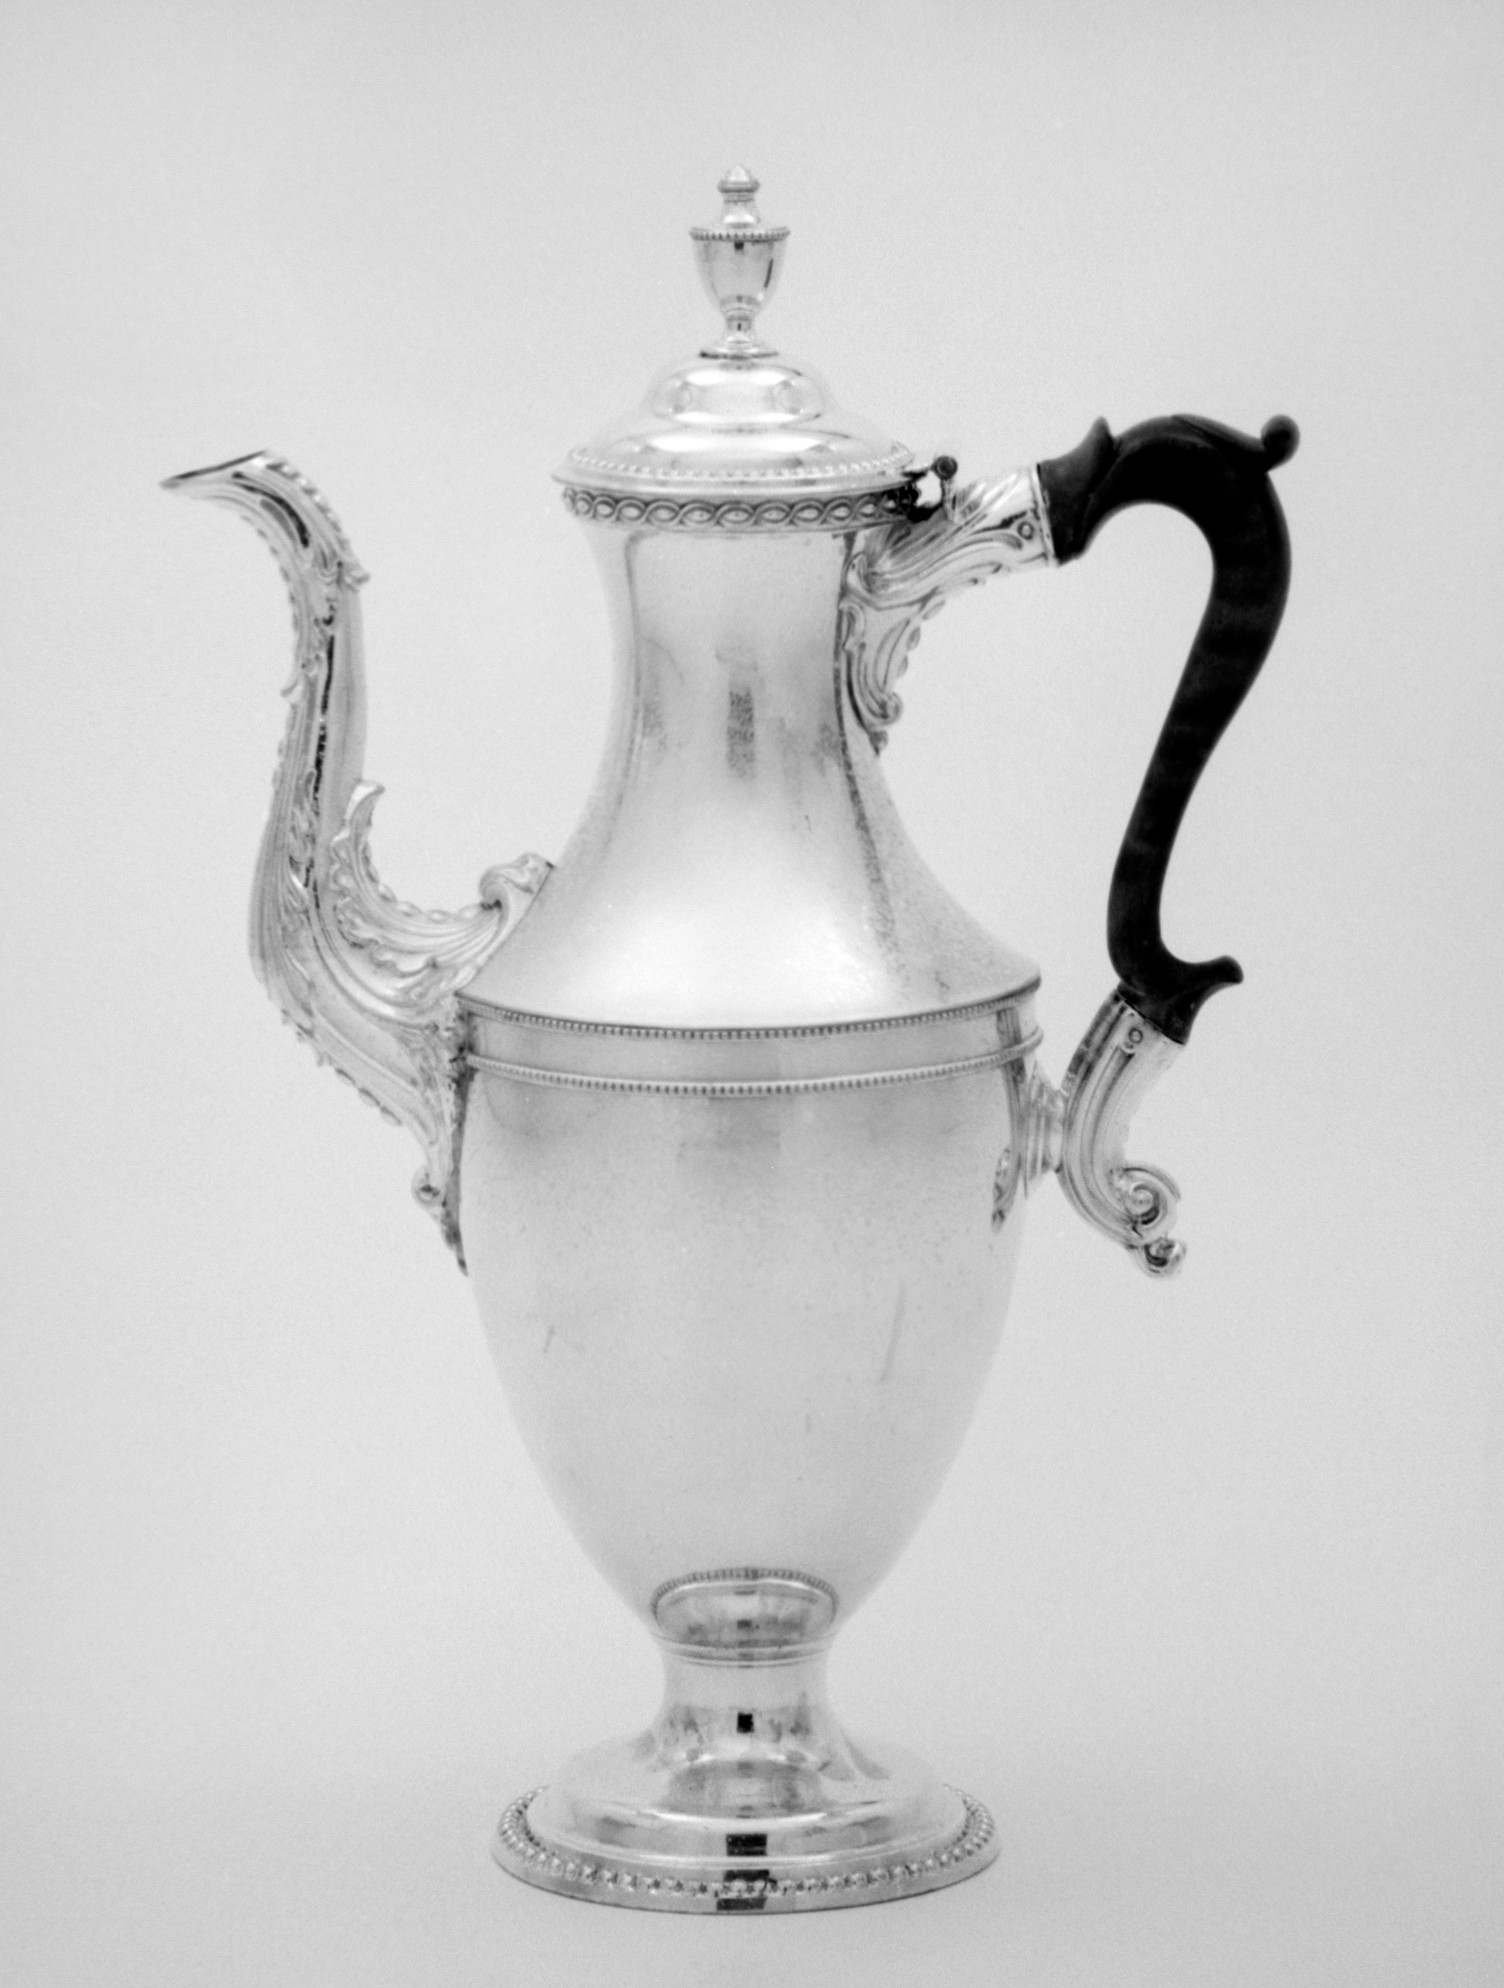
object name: coffeepot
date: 1701-1800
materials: metal, wood